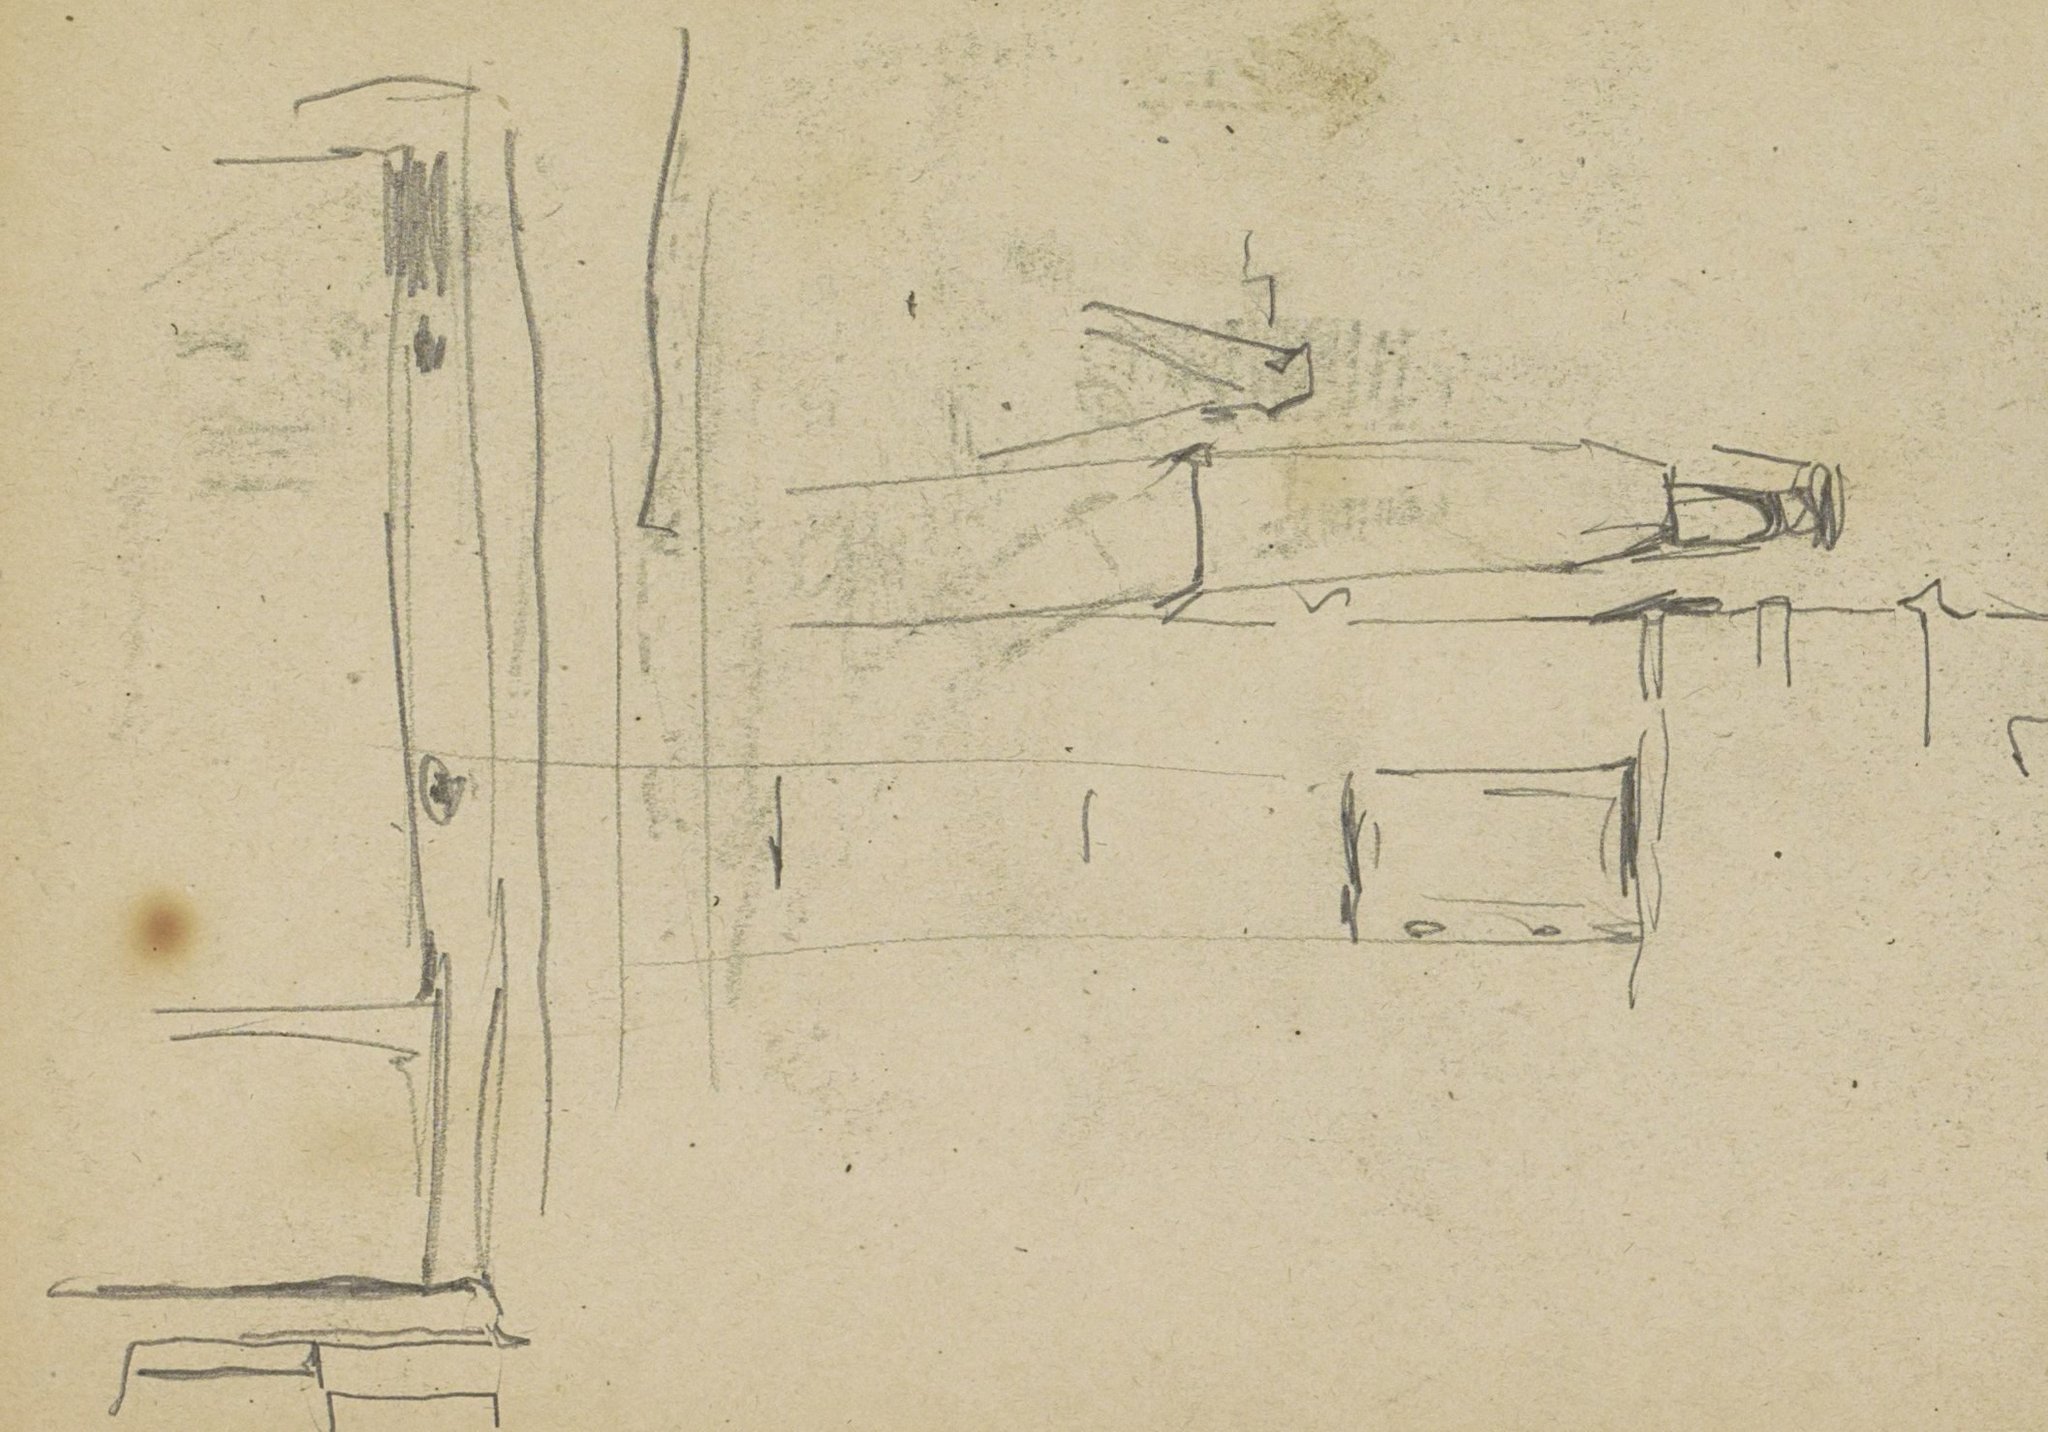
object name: sketchbook leaf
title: Architectuurstudies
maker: willem witsen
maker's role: draughtsman, painter, print maker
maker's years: 1860-1923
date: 1887-1920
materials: paper, pencil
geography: amsterdam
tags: stile, post, doorjamb, architectural detail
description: Mogelijk onder andere een kozijn. Pagina 30 uit een schetsboek met 12 bladen.